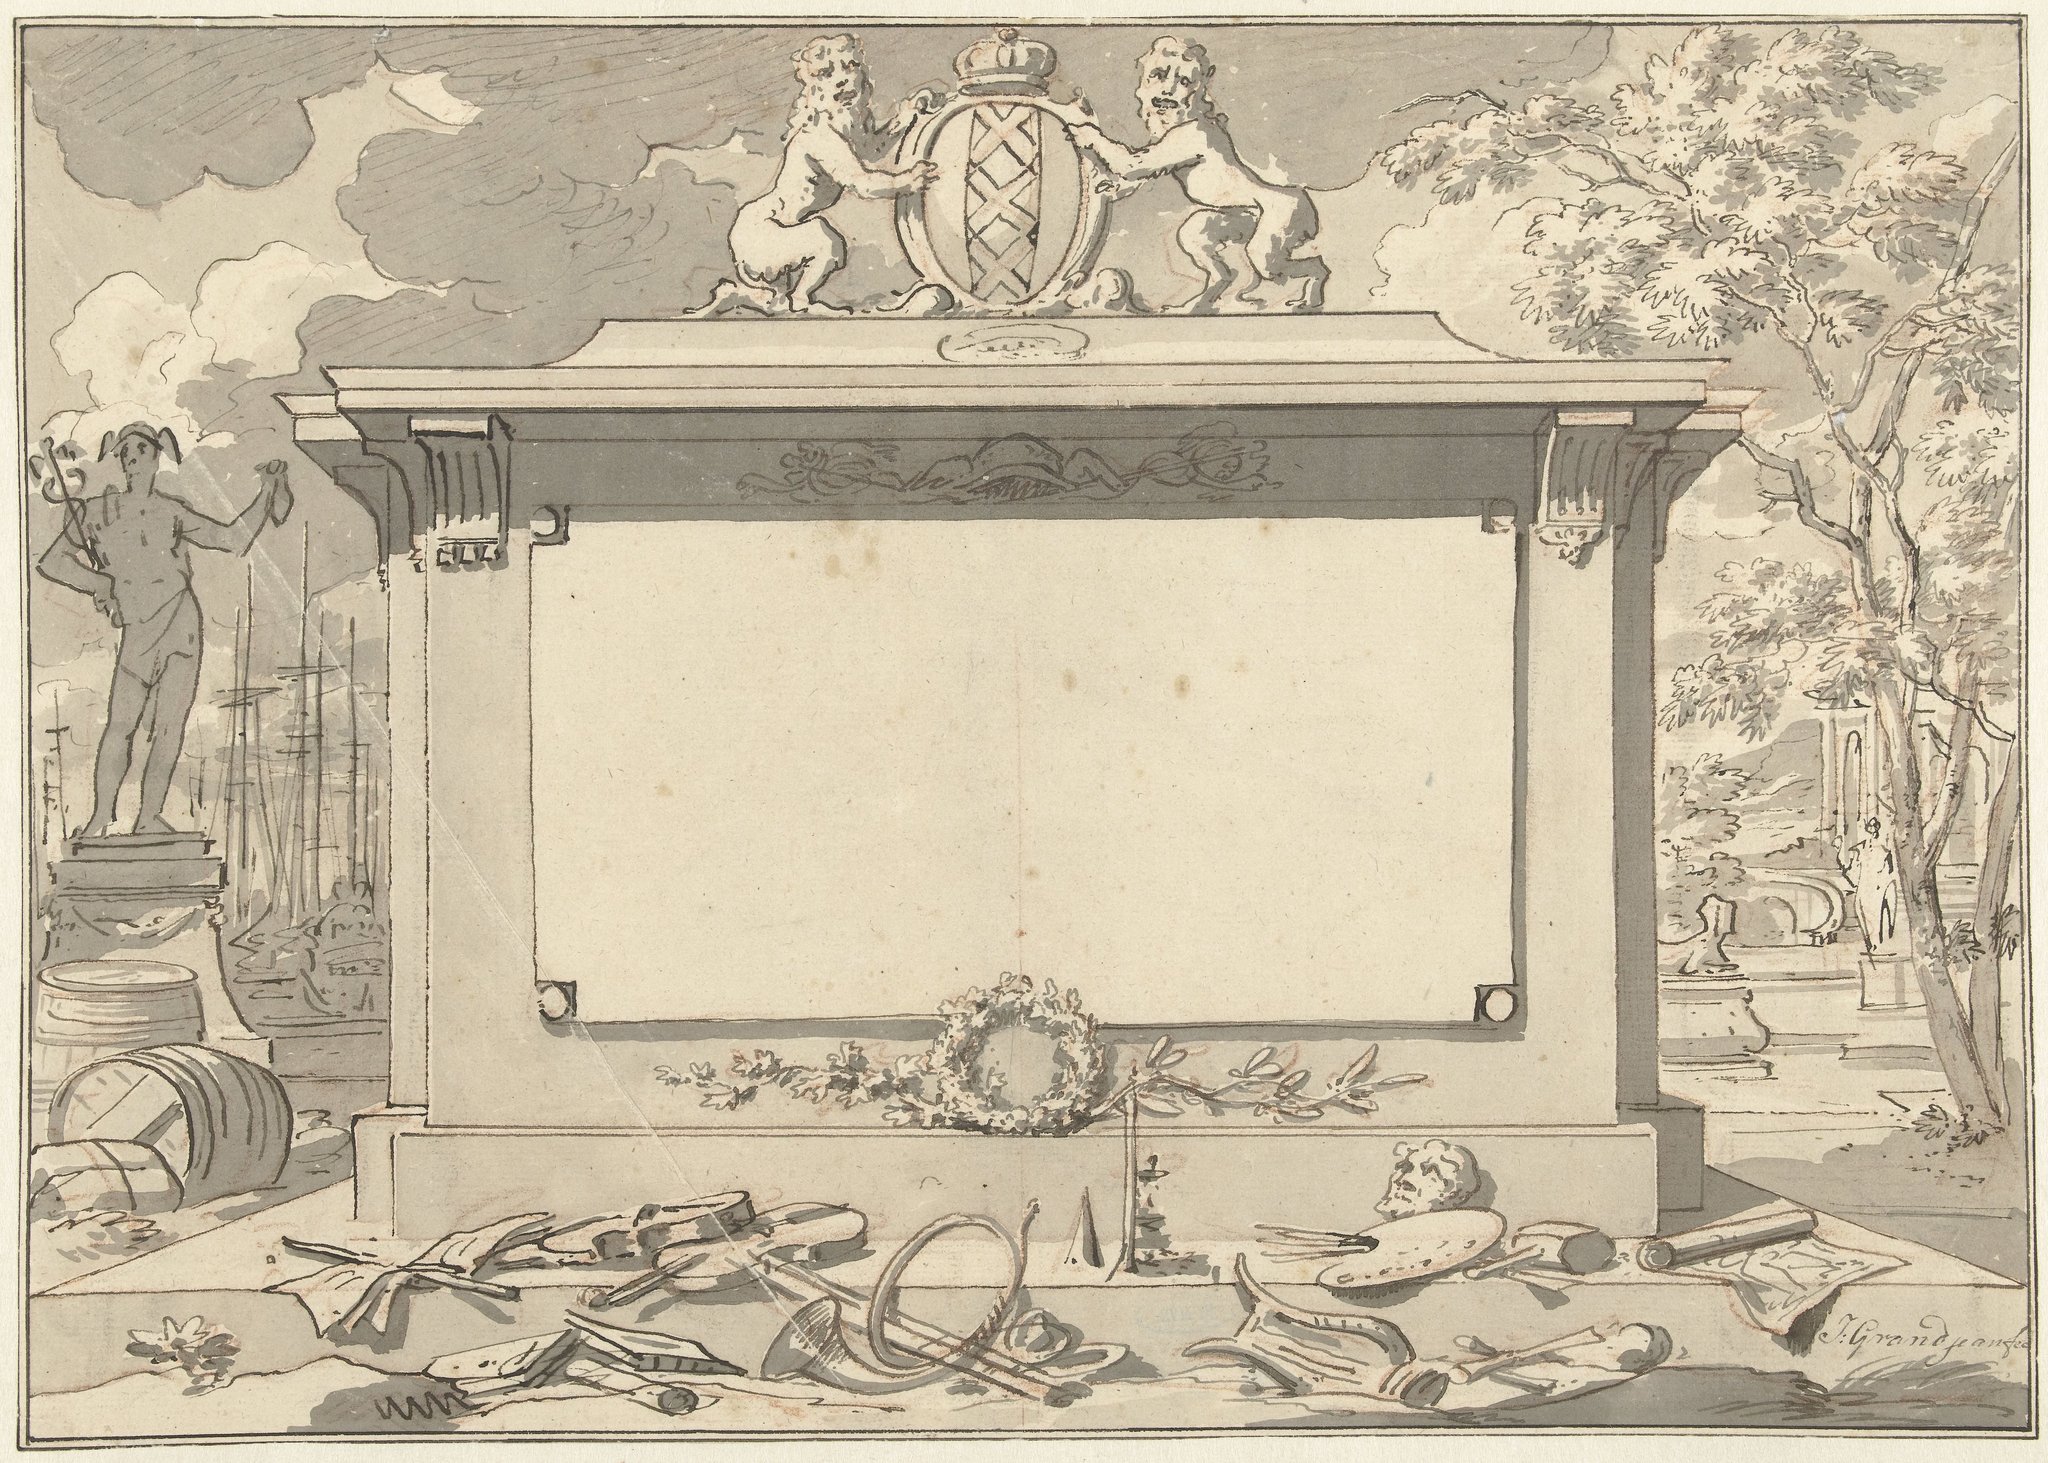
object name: drawing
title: Monument met attributen van Amsterdam, de koopvaart en de kunsten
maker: jean grandjean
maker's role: draughtsman, print maker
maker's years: 1752-1781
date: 1765-1781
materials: chalk, ink, paper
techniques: brush, pen